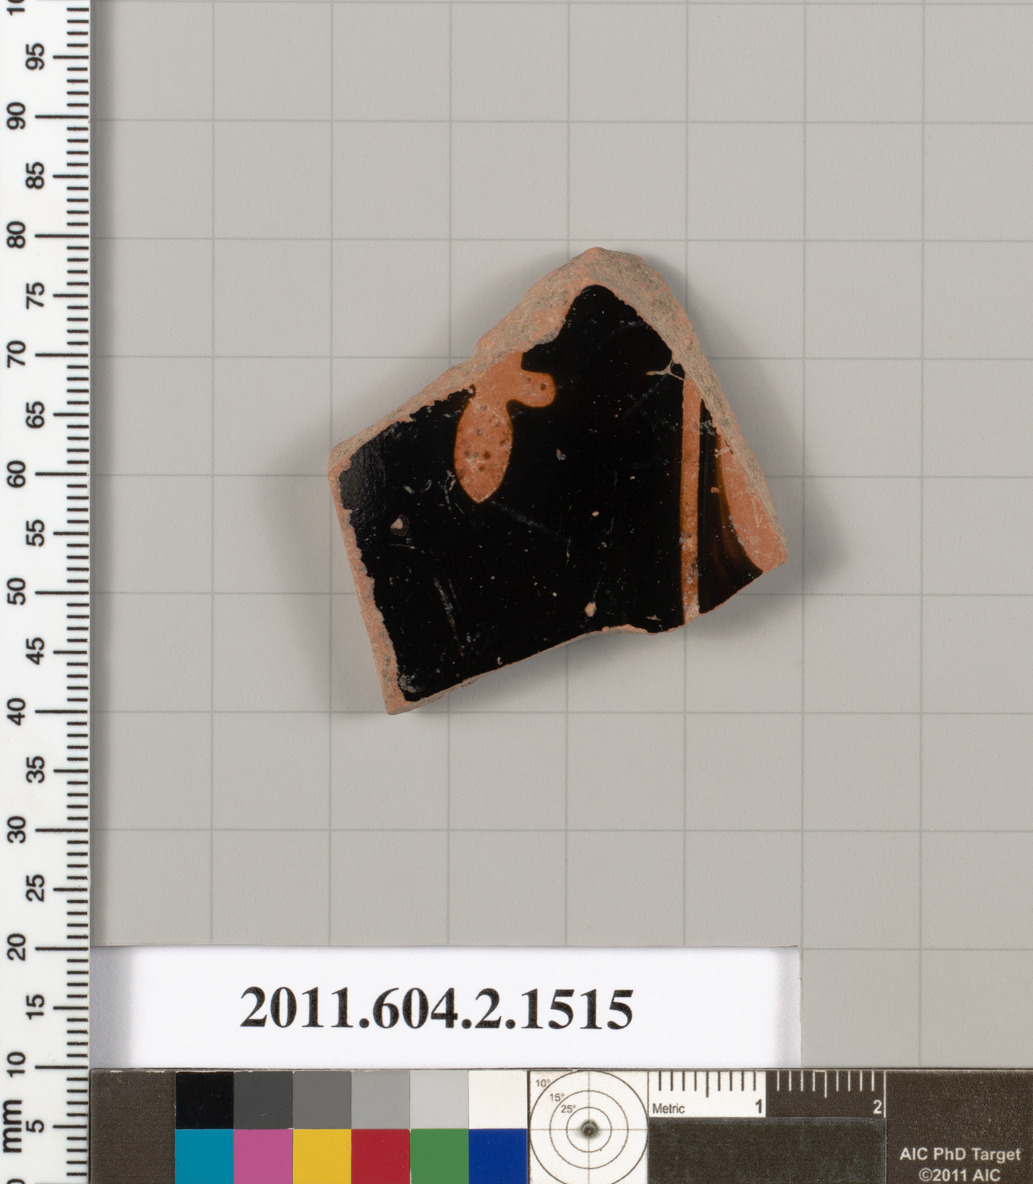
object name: skyphos fragment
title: Terracotta fragment of a skyphos (deep drinking cup)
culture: greek, attic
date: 450-426 BCE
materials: terracotta